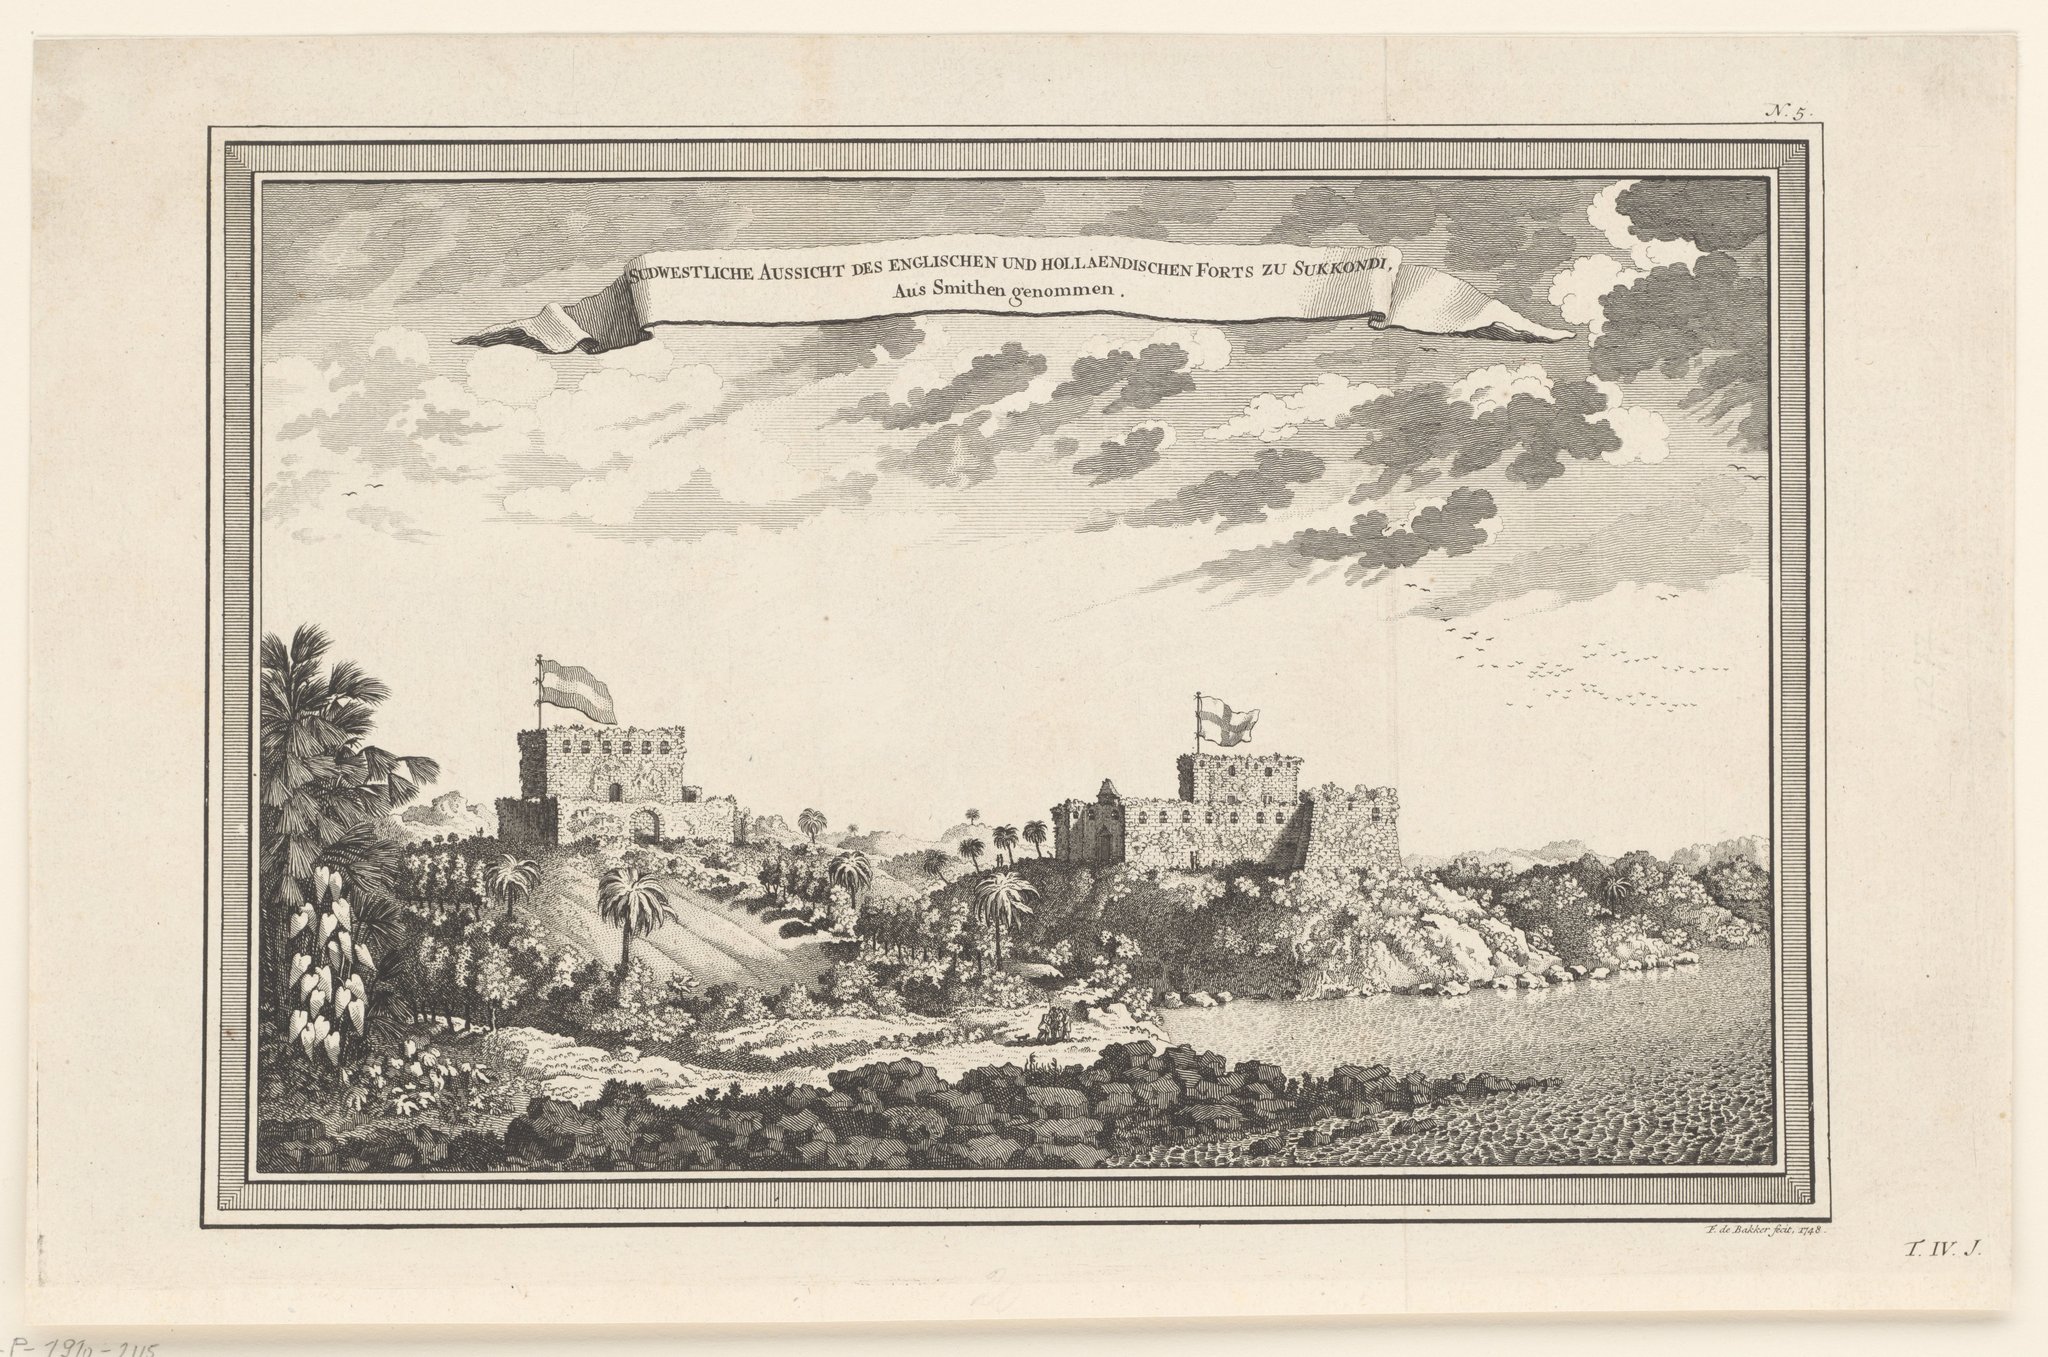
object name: print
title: Gezicht op het Engelse fort en het Fort Oranje in Sekondi vanuit het Zuidwesten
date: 1748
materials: paper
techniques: etching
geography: amsterdam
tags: fortifications, military engineering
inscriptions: collector's mark: Lugt 2228